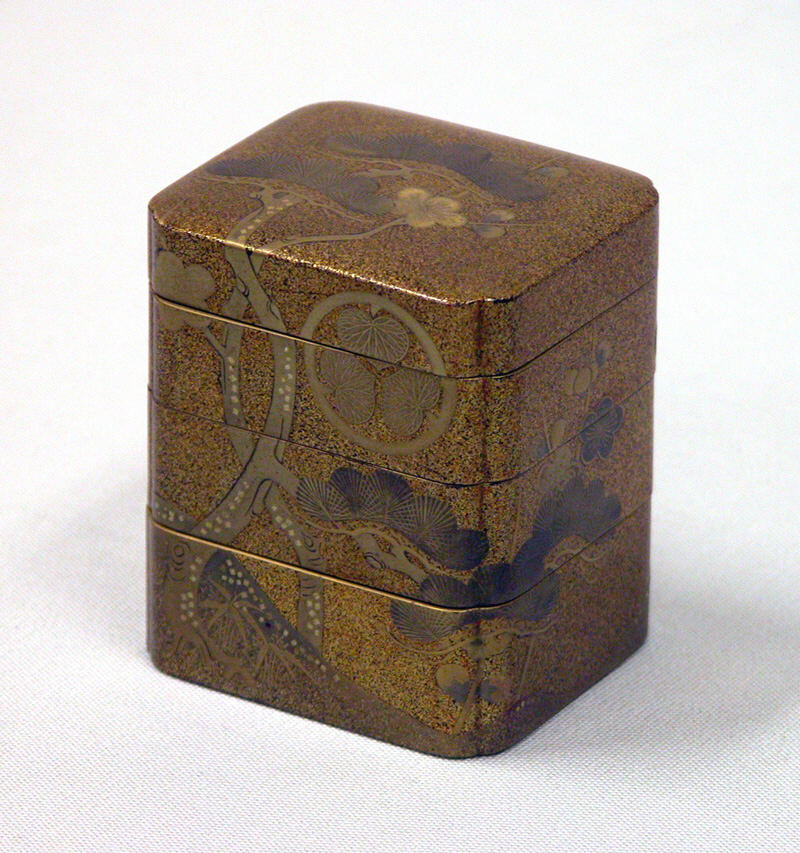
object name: incense box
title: Incense Box in Three Compartments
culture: japanese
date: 1834-1866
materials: gold, lacquer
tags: trees